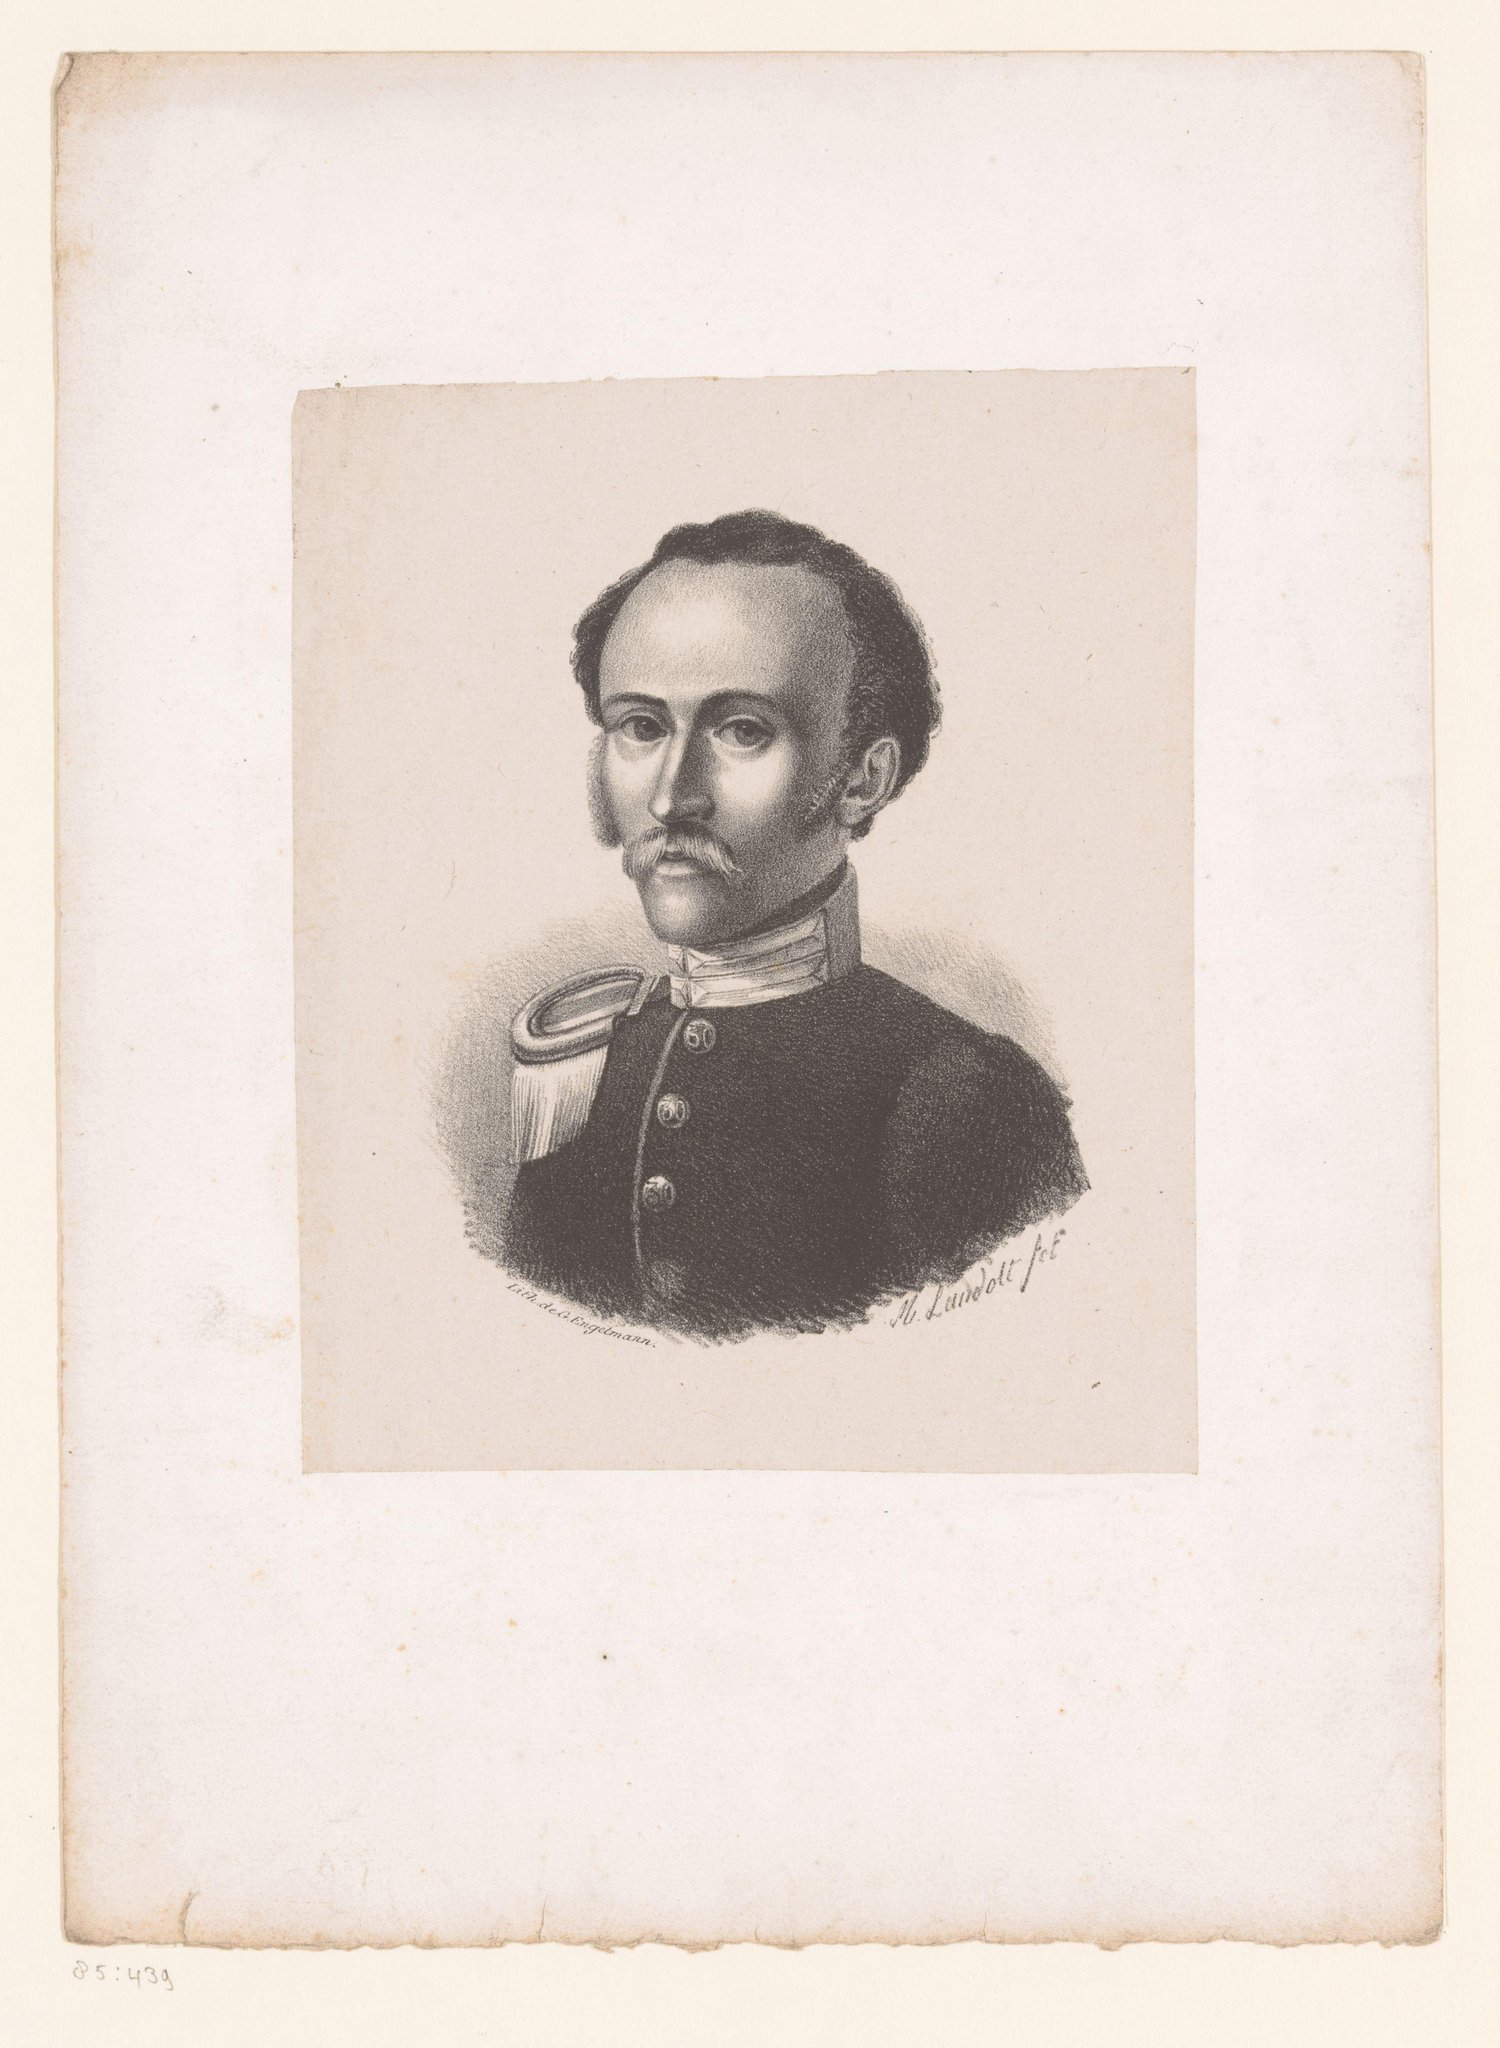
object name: print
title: Portret van een onbekende Zwitserse militair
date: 1823-1827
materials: paper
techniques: lithograph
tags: anonymous historical person portrayed, officer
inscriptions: collector's mark: Lugt 2760, collector's mark: Lugt 2228a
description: Verschenen in een serie van in ieder geval 74 portretten van Zwitserse militairen. Een aantal daarvan is gedateerd 1823 en 1824. De serie bevat ook een portret van de prentmaker, die tevens militair was, in de functie van kapitein (zie https://www.graphikportal.org/document/gpo00156499). Hij werd in 1827 bevoorderd tot majoor.